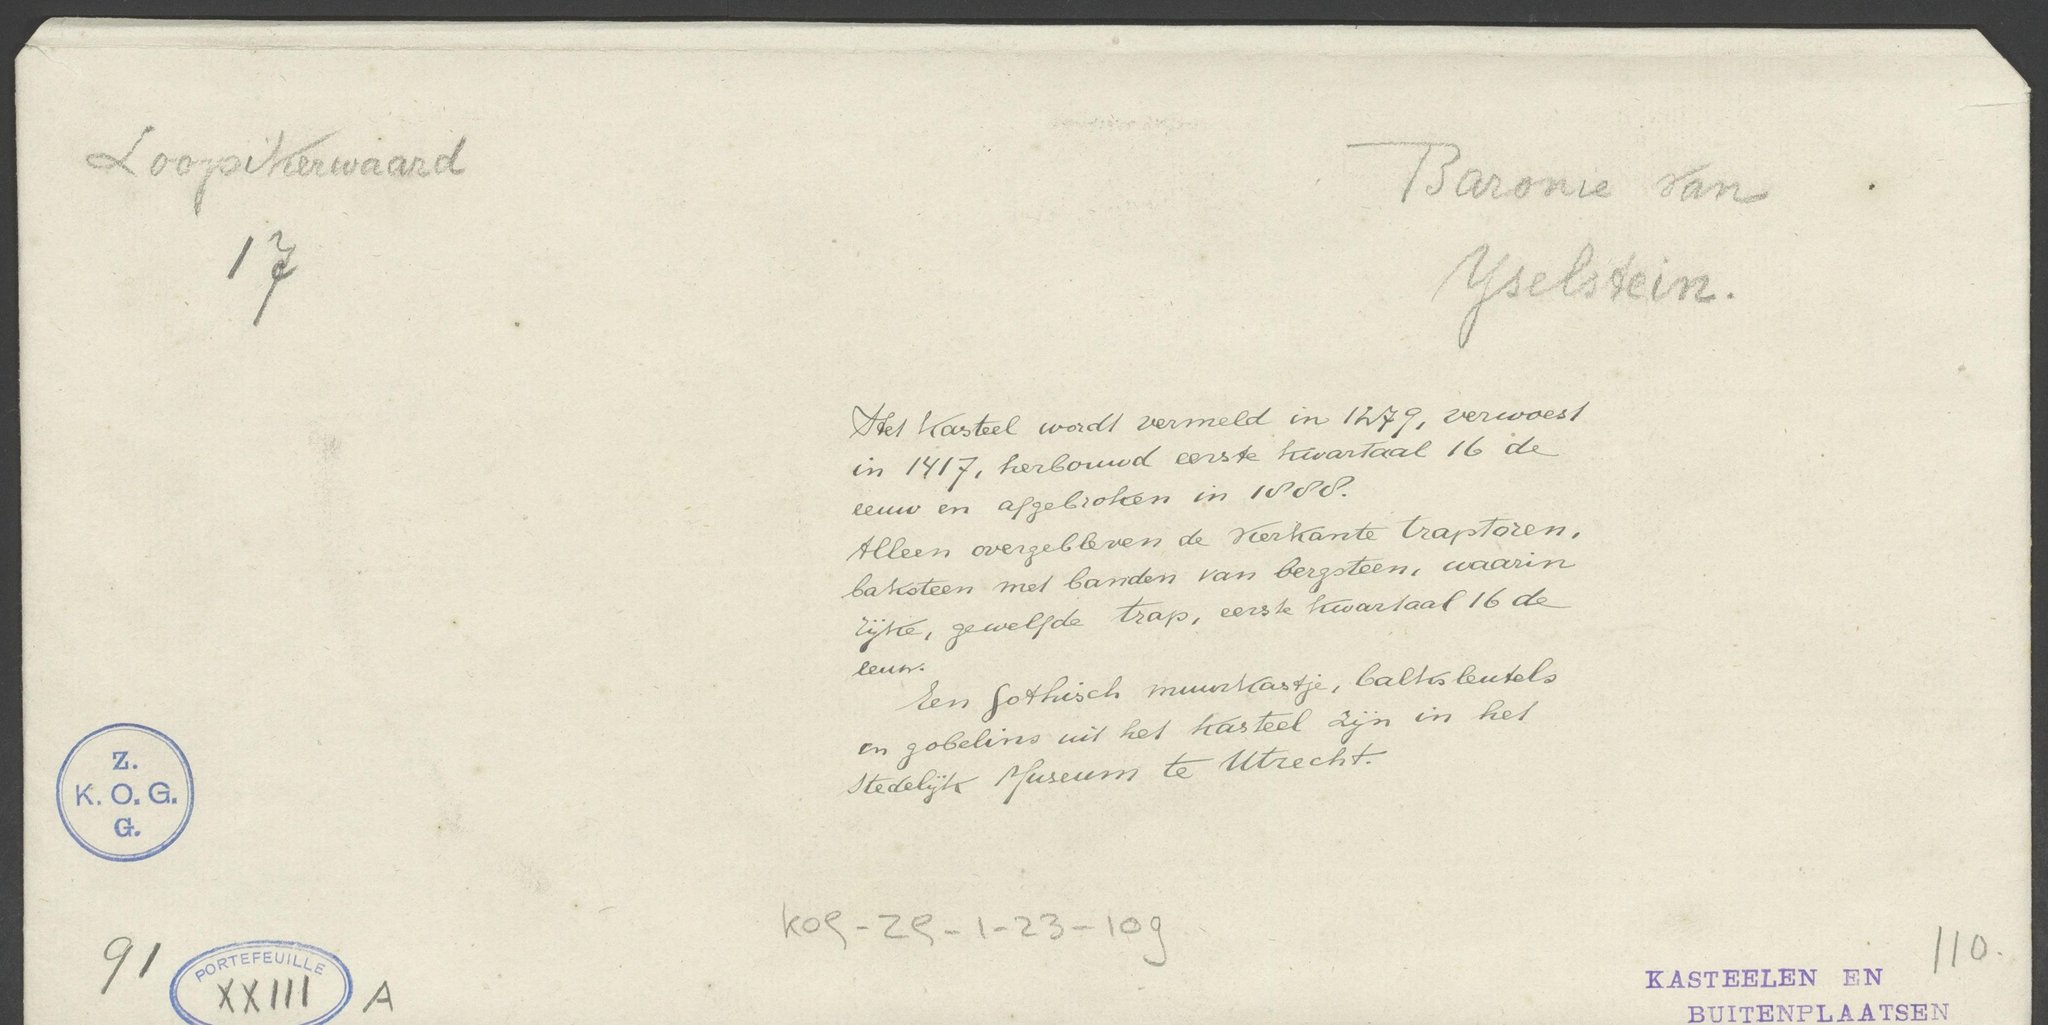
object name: envelope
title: Envelop met de geschiedenis van Kasteel IJsselstein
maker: Anonymous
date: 1867-1887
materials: ink, paper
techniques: pen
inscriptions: stamp, stamp, collector's mark: Lugt 1641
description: Onderwerpsrubrieken binnen de Atlas Zeden en Gewoonten: Zeden en Gewoonten in Engeren Zin, De Woning. Kastelen en buitenplaatsen. Holland (vervolg.)